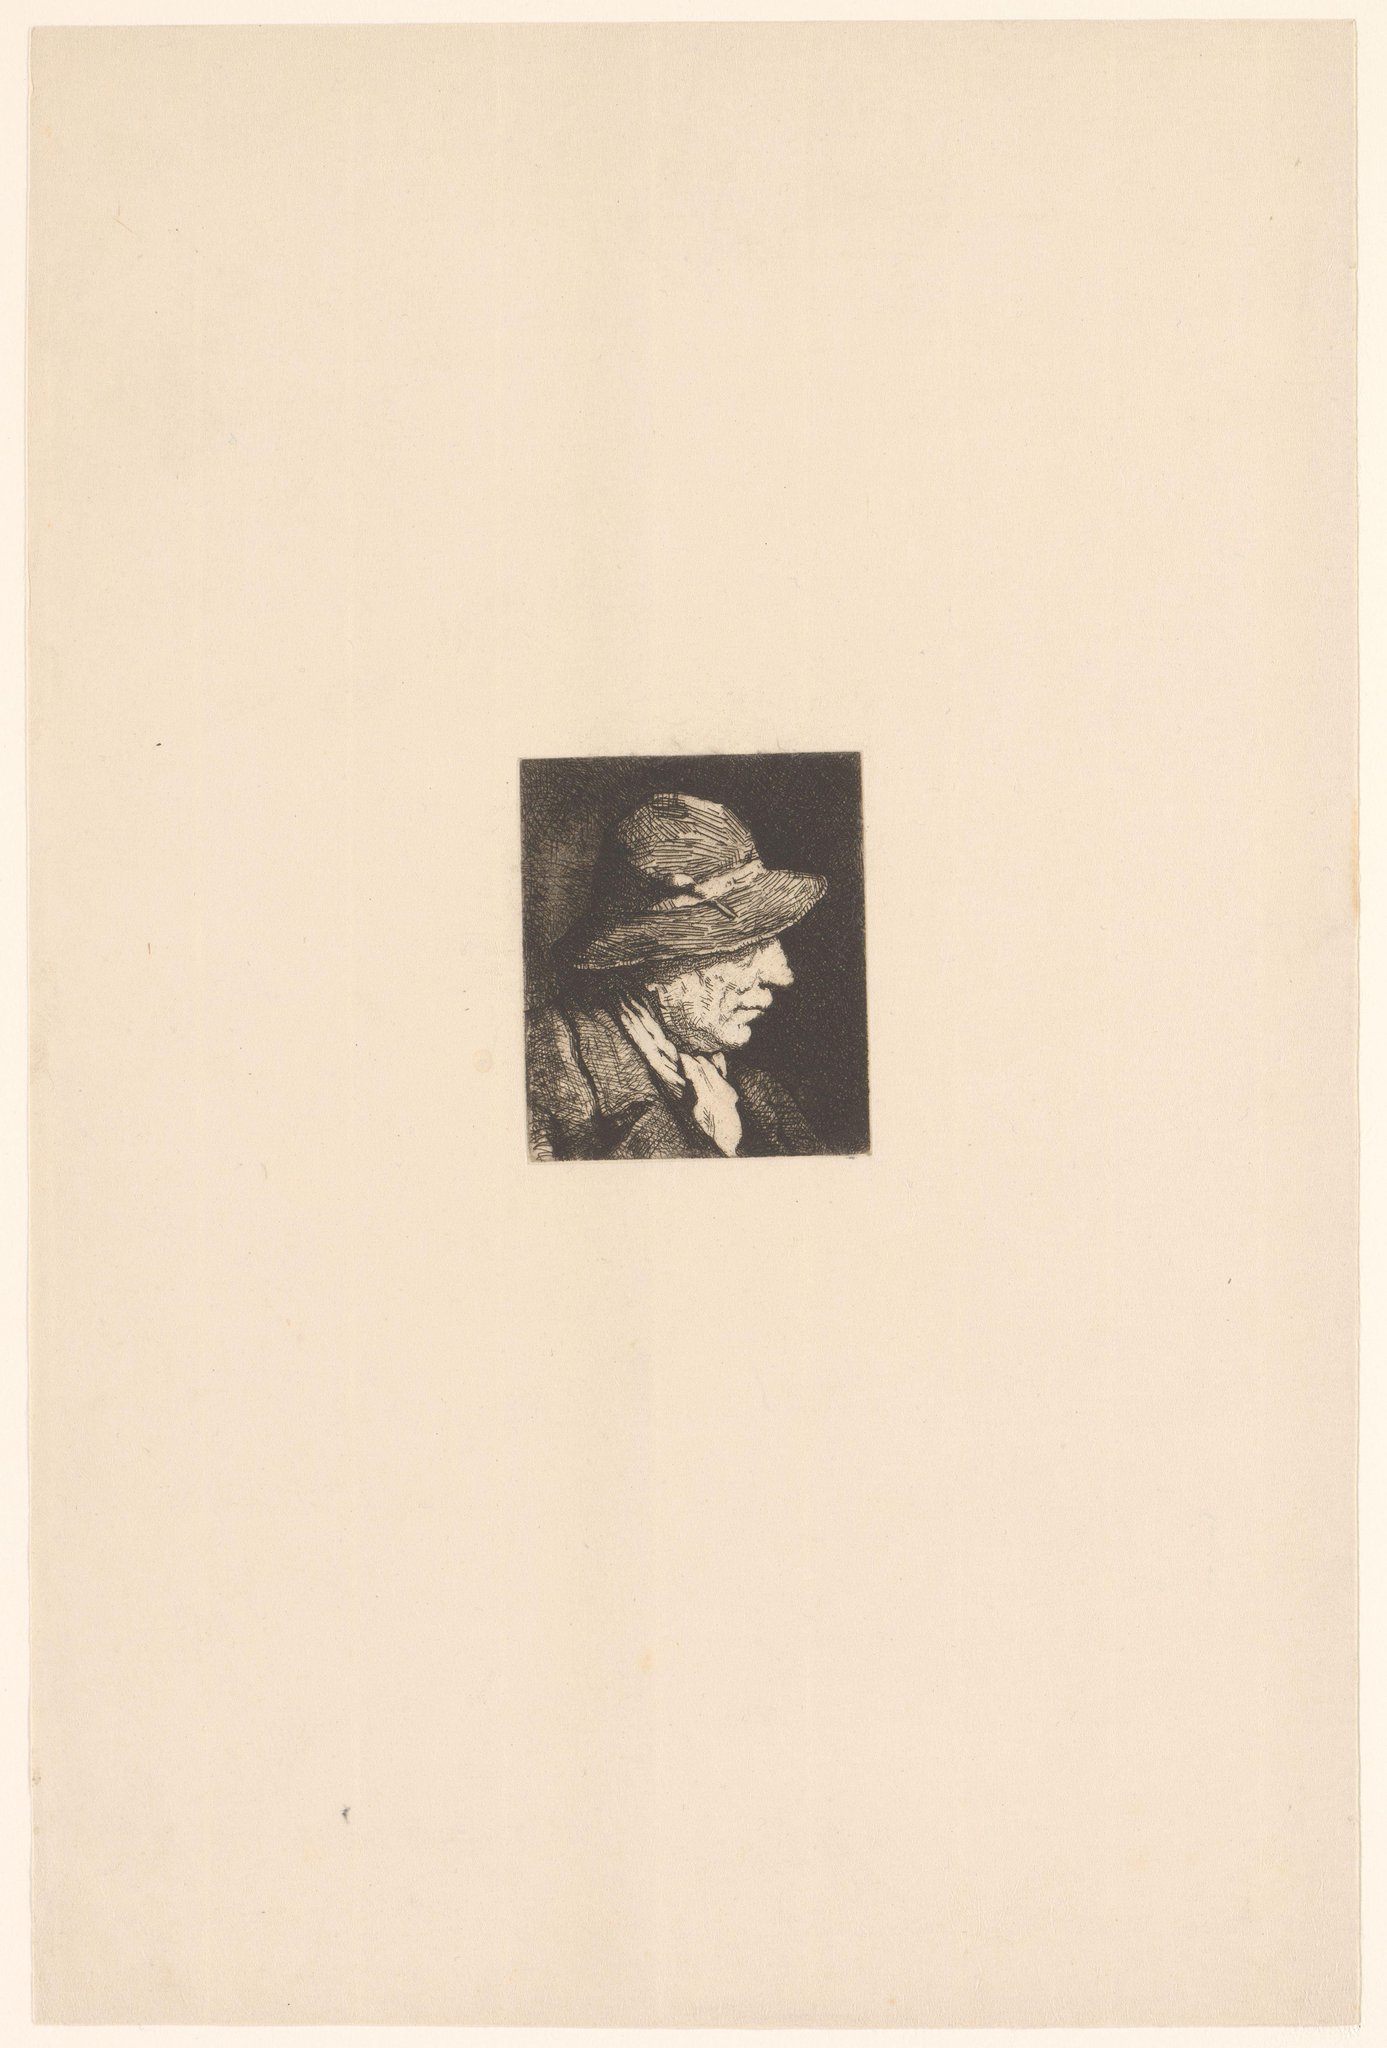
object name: print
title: Hoofd van een man met hoed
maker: piet verhaert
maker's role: print maker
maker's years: 1852-1908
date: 1879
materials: paper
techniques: etching, intaglio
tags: head-gear, adult man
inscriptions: collector's mark: Lugt 2228